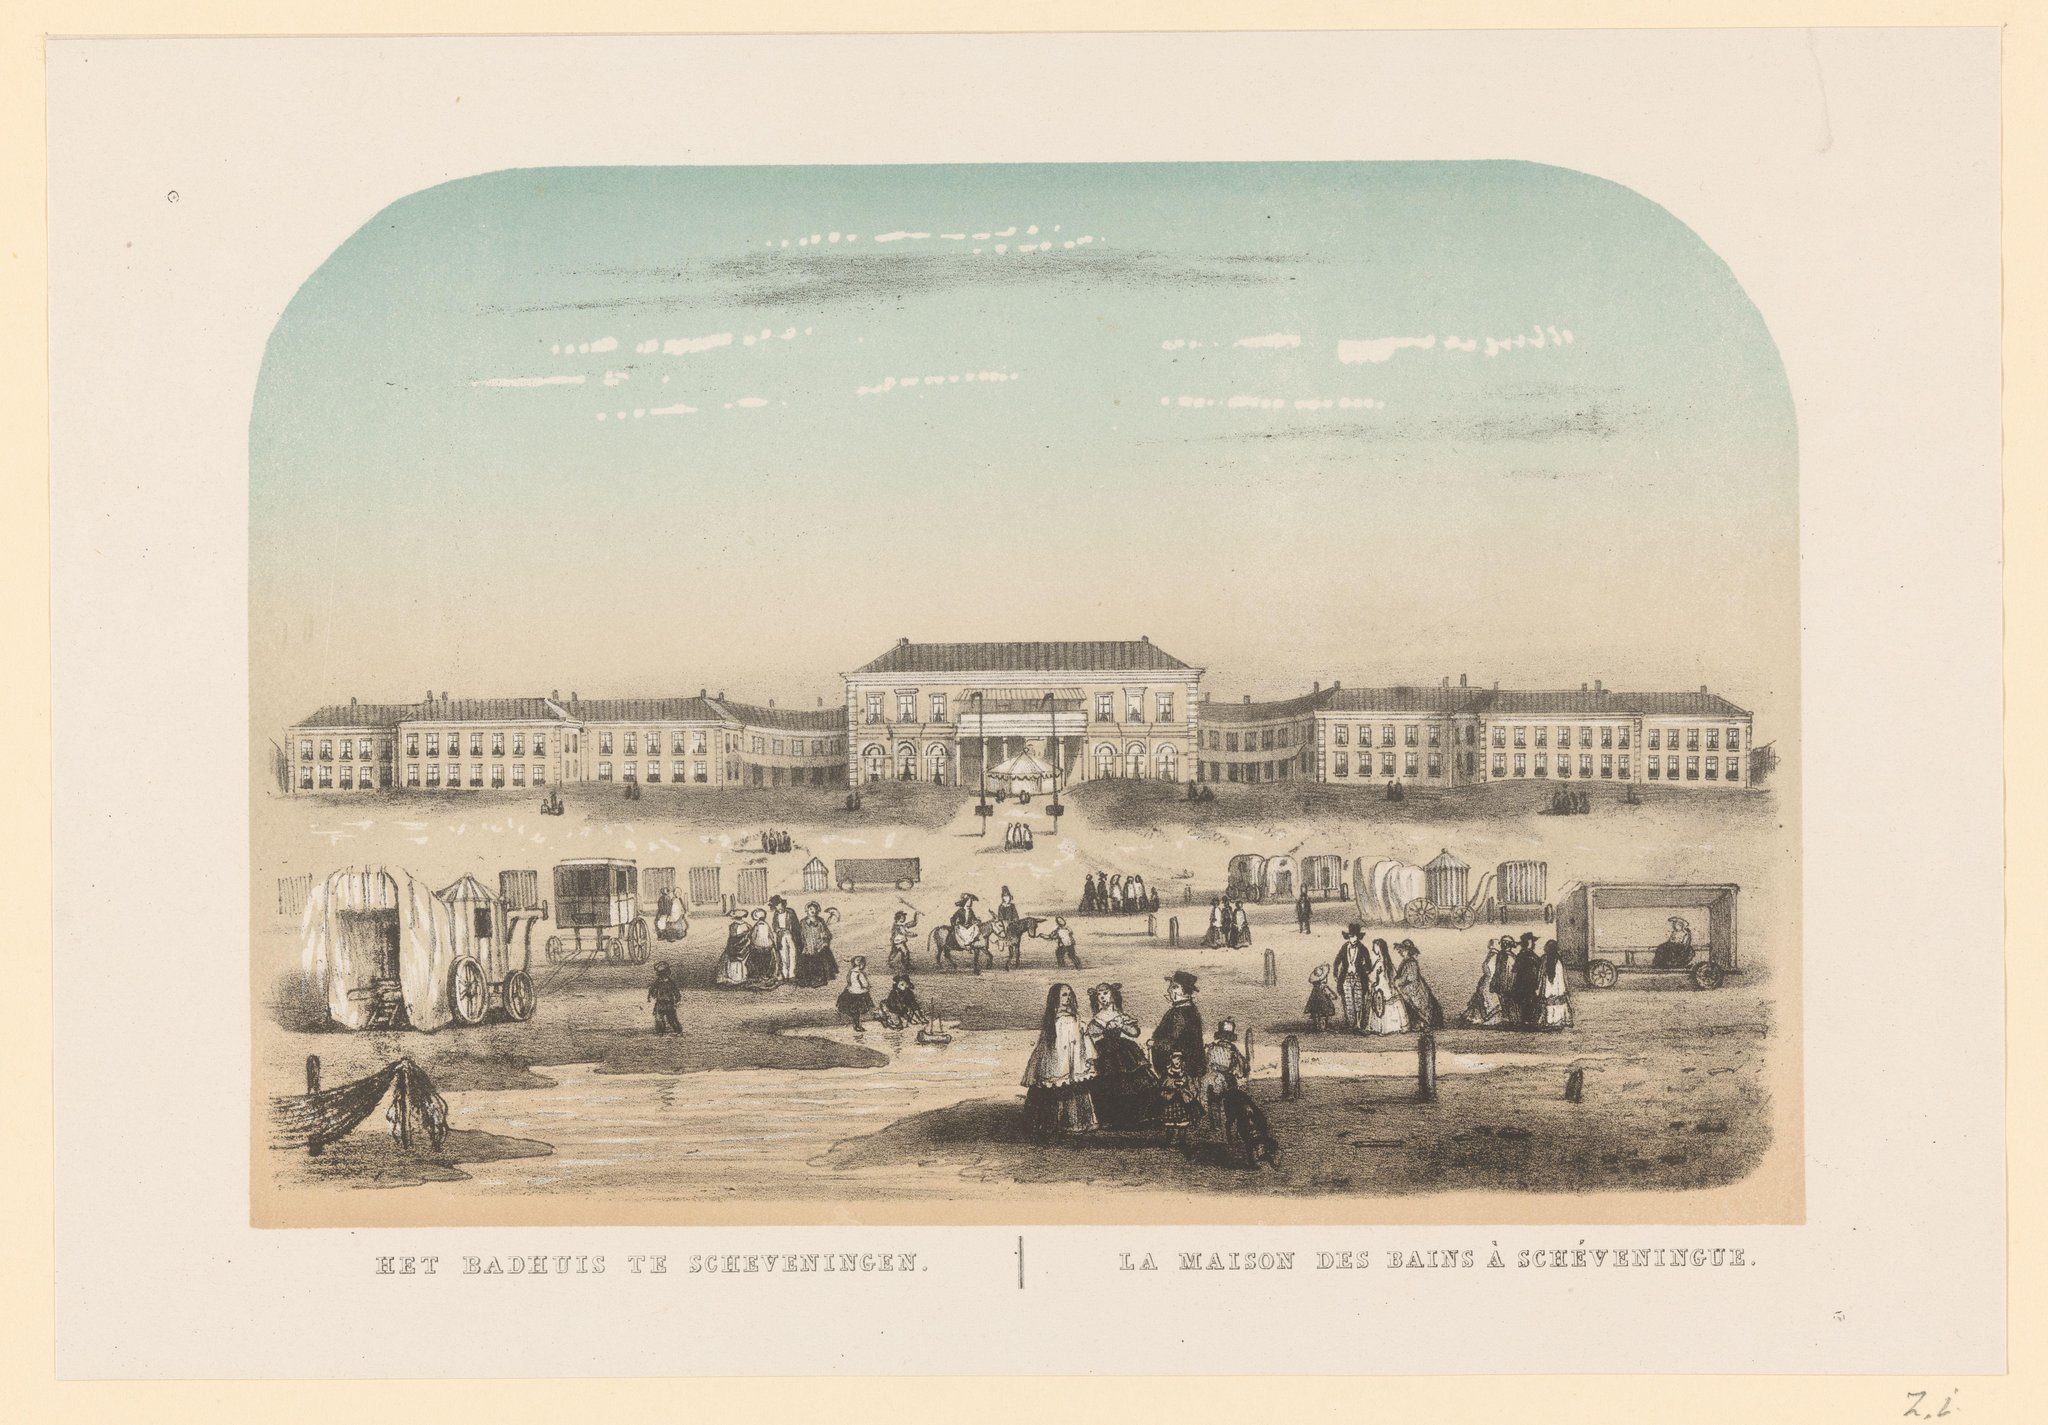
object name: print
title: Gezicht op het Badhuis in Scheveningen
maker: Anonymous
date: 1800-1899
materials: paper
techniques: tone lithography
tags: public baths, beach